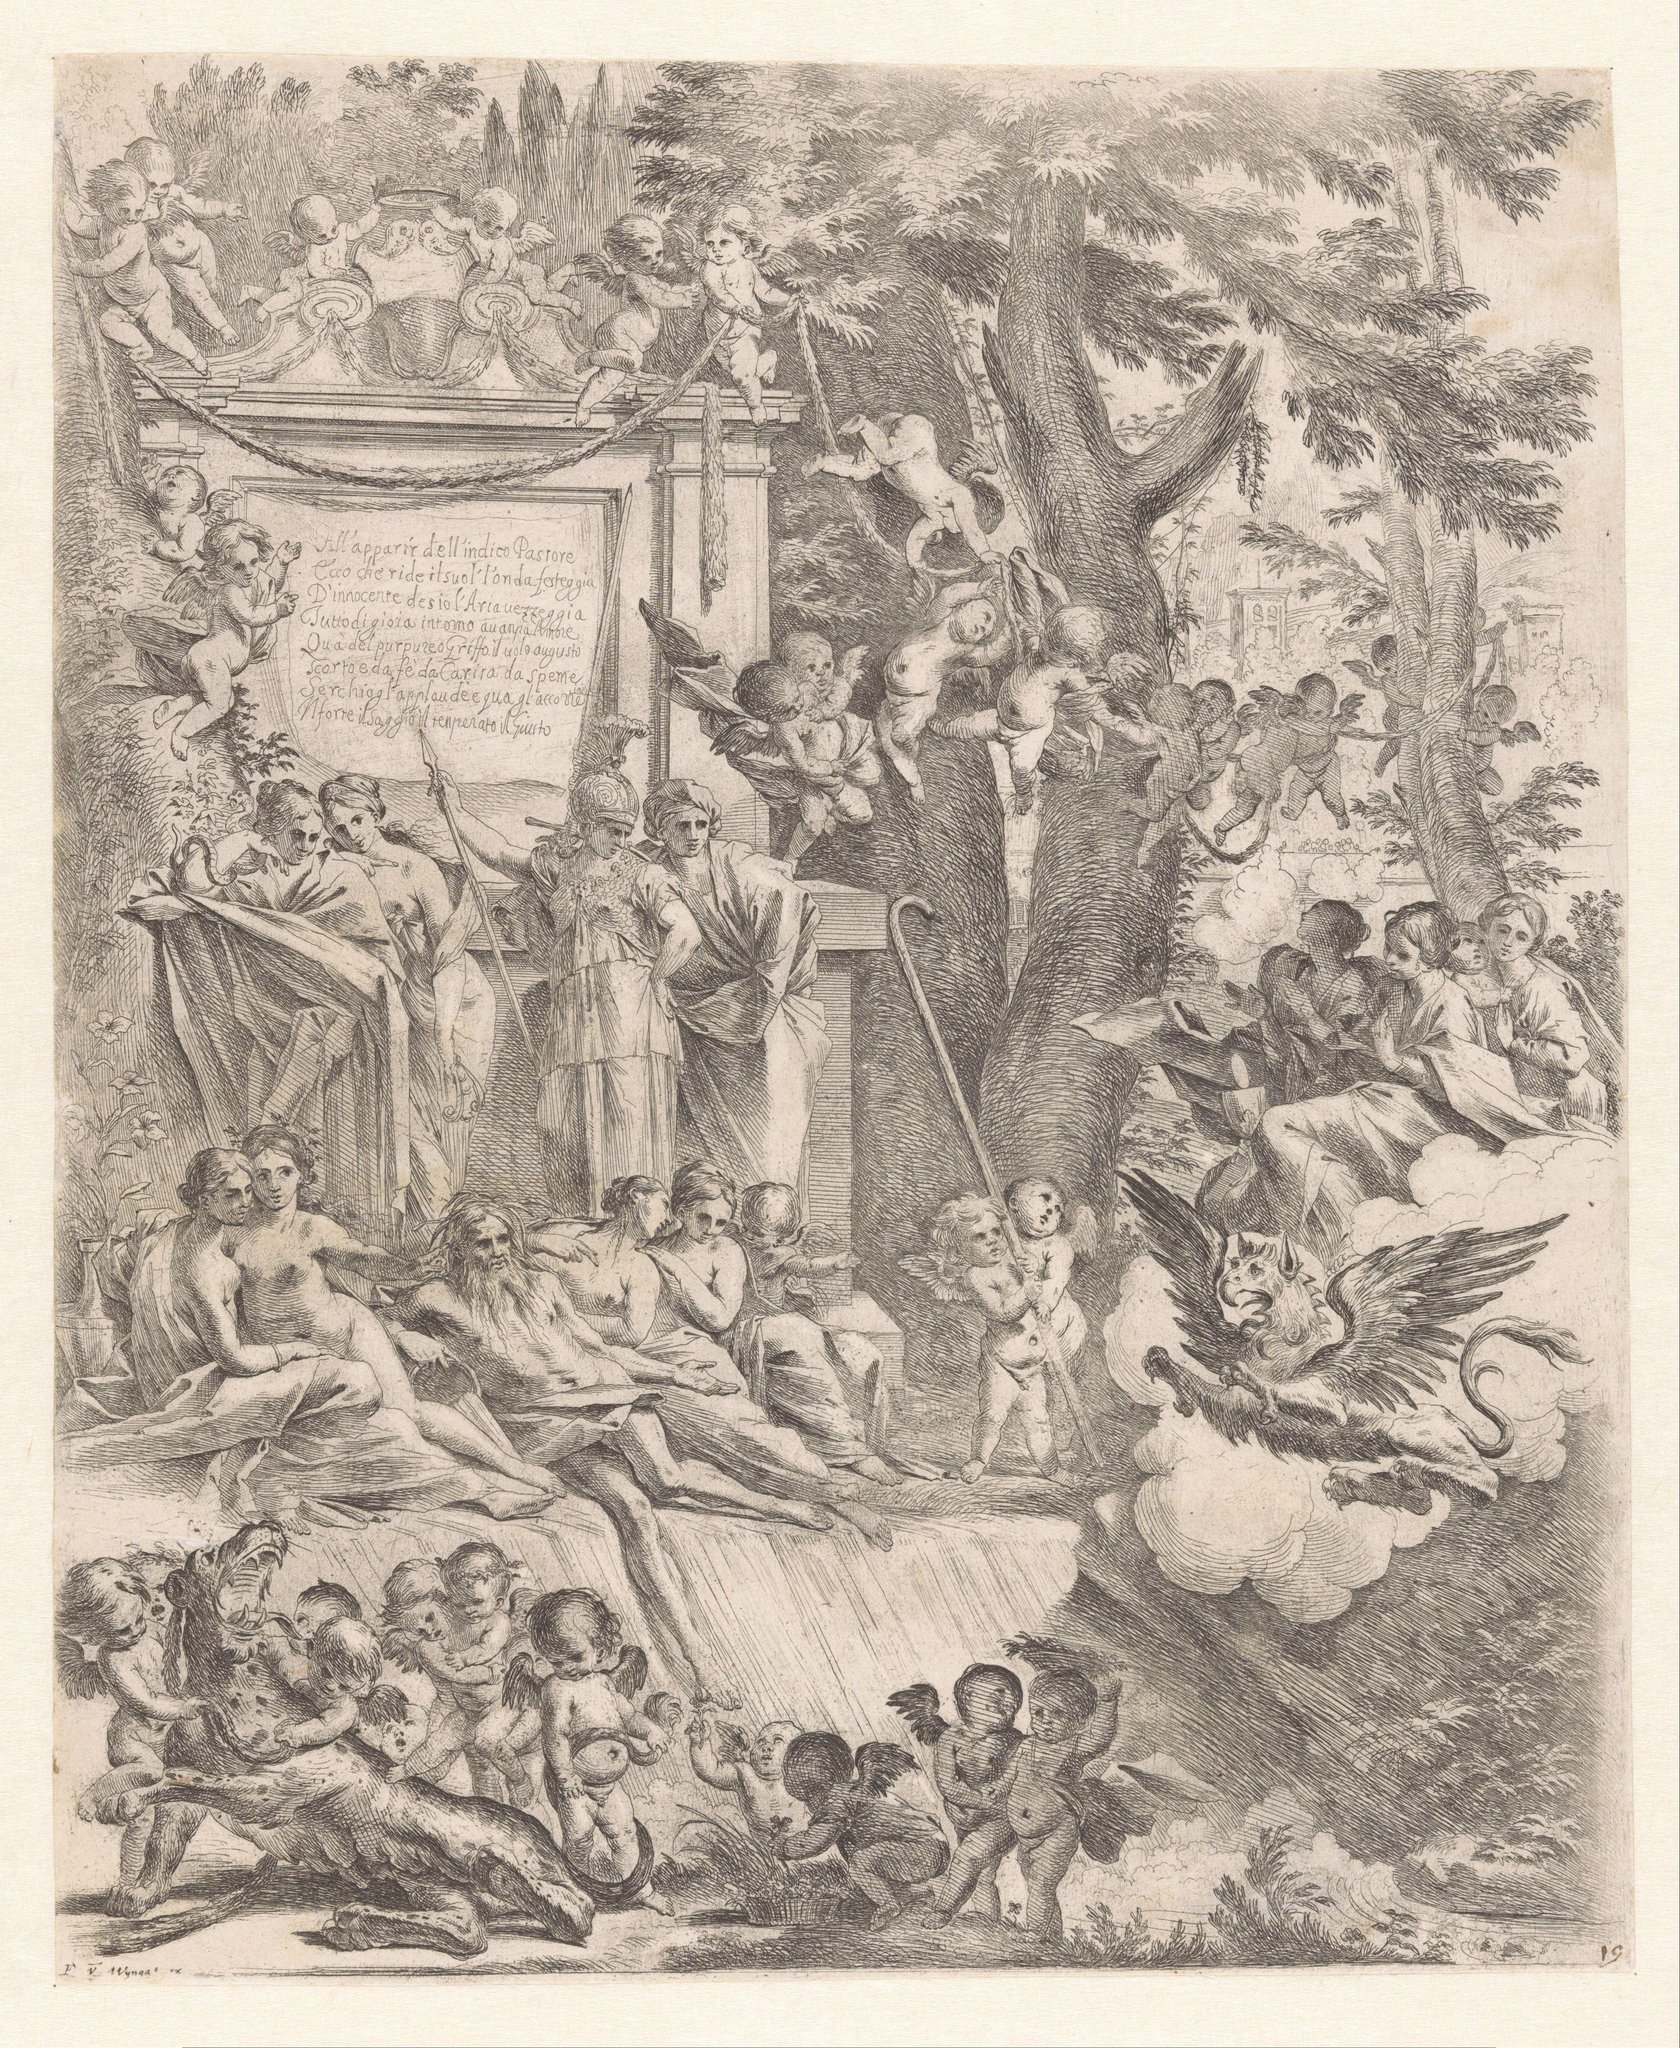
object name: print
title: Allegorie op de benoeming van Marcantonio Franciotti tot bisschop van Lucca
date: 1637-1638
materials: paper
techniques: etching, intaglio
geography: italy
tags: griffin (lion/eagle); 'griffo' (ripa), beasts of prey, predatory animals: panther, (story of) minerva (pallas, athena), the three theological virtues, cupids: 'amores', 'amoretti', 'putti'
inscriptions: number: ‘19’, collector's mark: ‘Hinloopen’, collector's mark: Lugt 11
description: Allegorische voorstelling ter ere van de benoeming van kardinaal Marcantonio Franciotti tot bisschop van Lucca. Een stenen monument omgeven door allegorische figuren, goden en putti. Rechts een griffioen en links een panter. Rechts op de achtergrond ligt de stad Lucca.